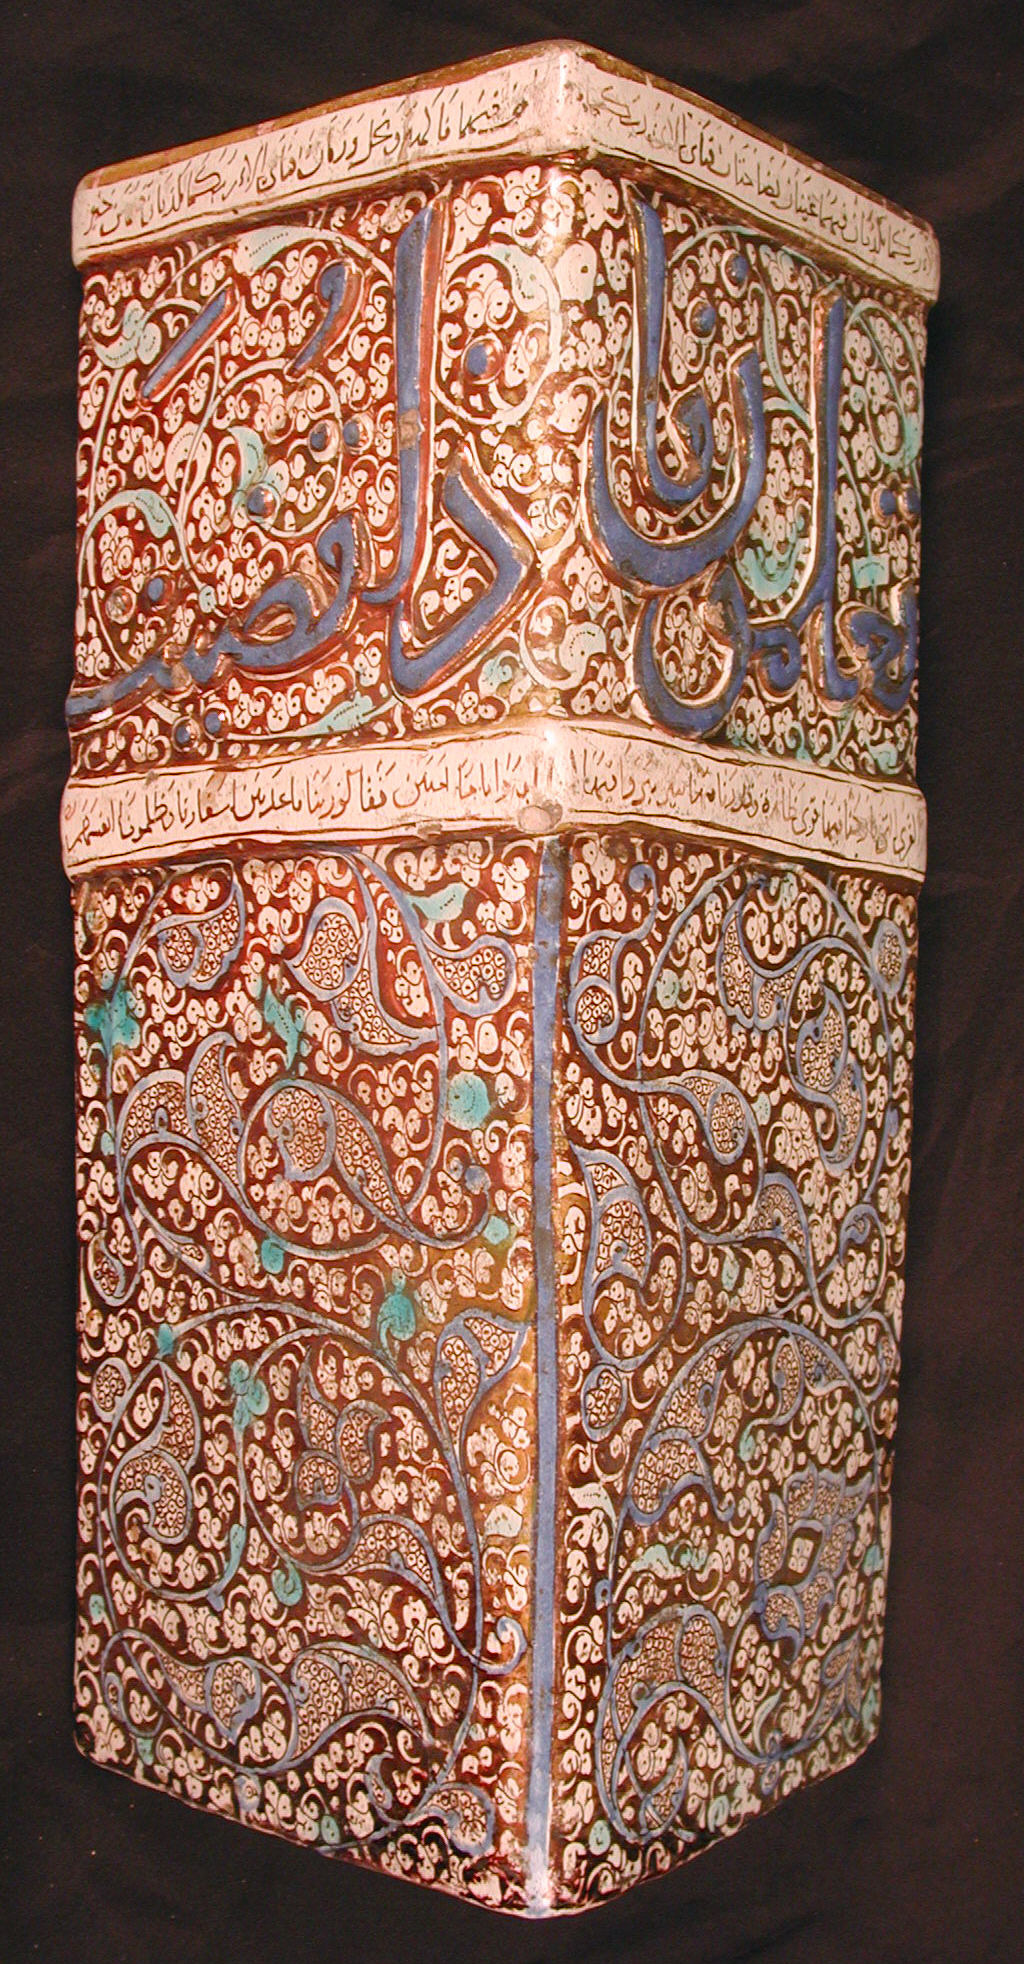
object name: corner tile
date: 1301-1333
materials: glaze, stonepaste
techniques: luster painting, painting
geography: iran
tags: arabic